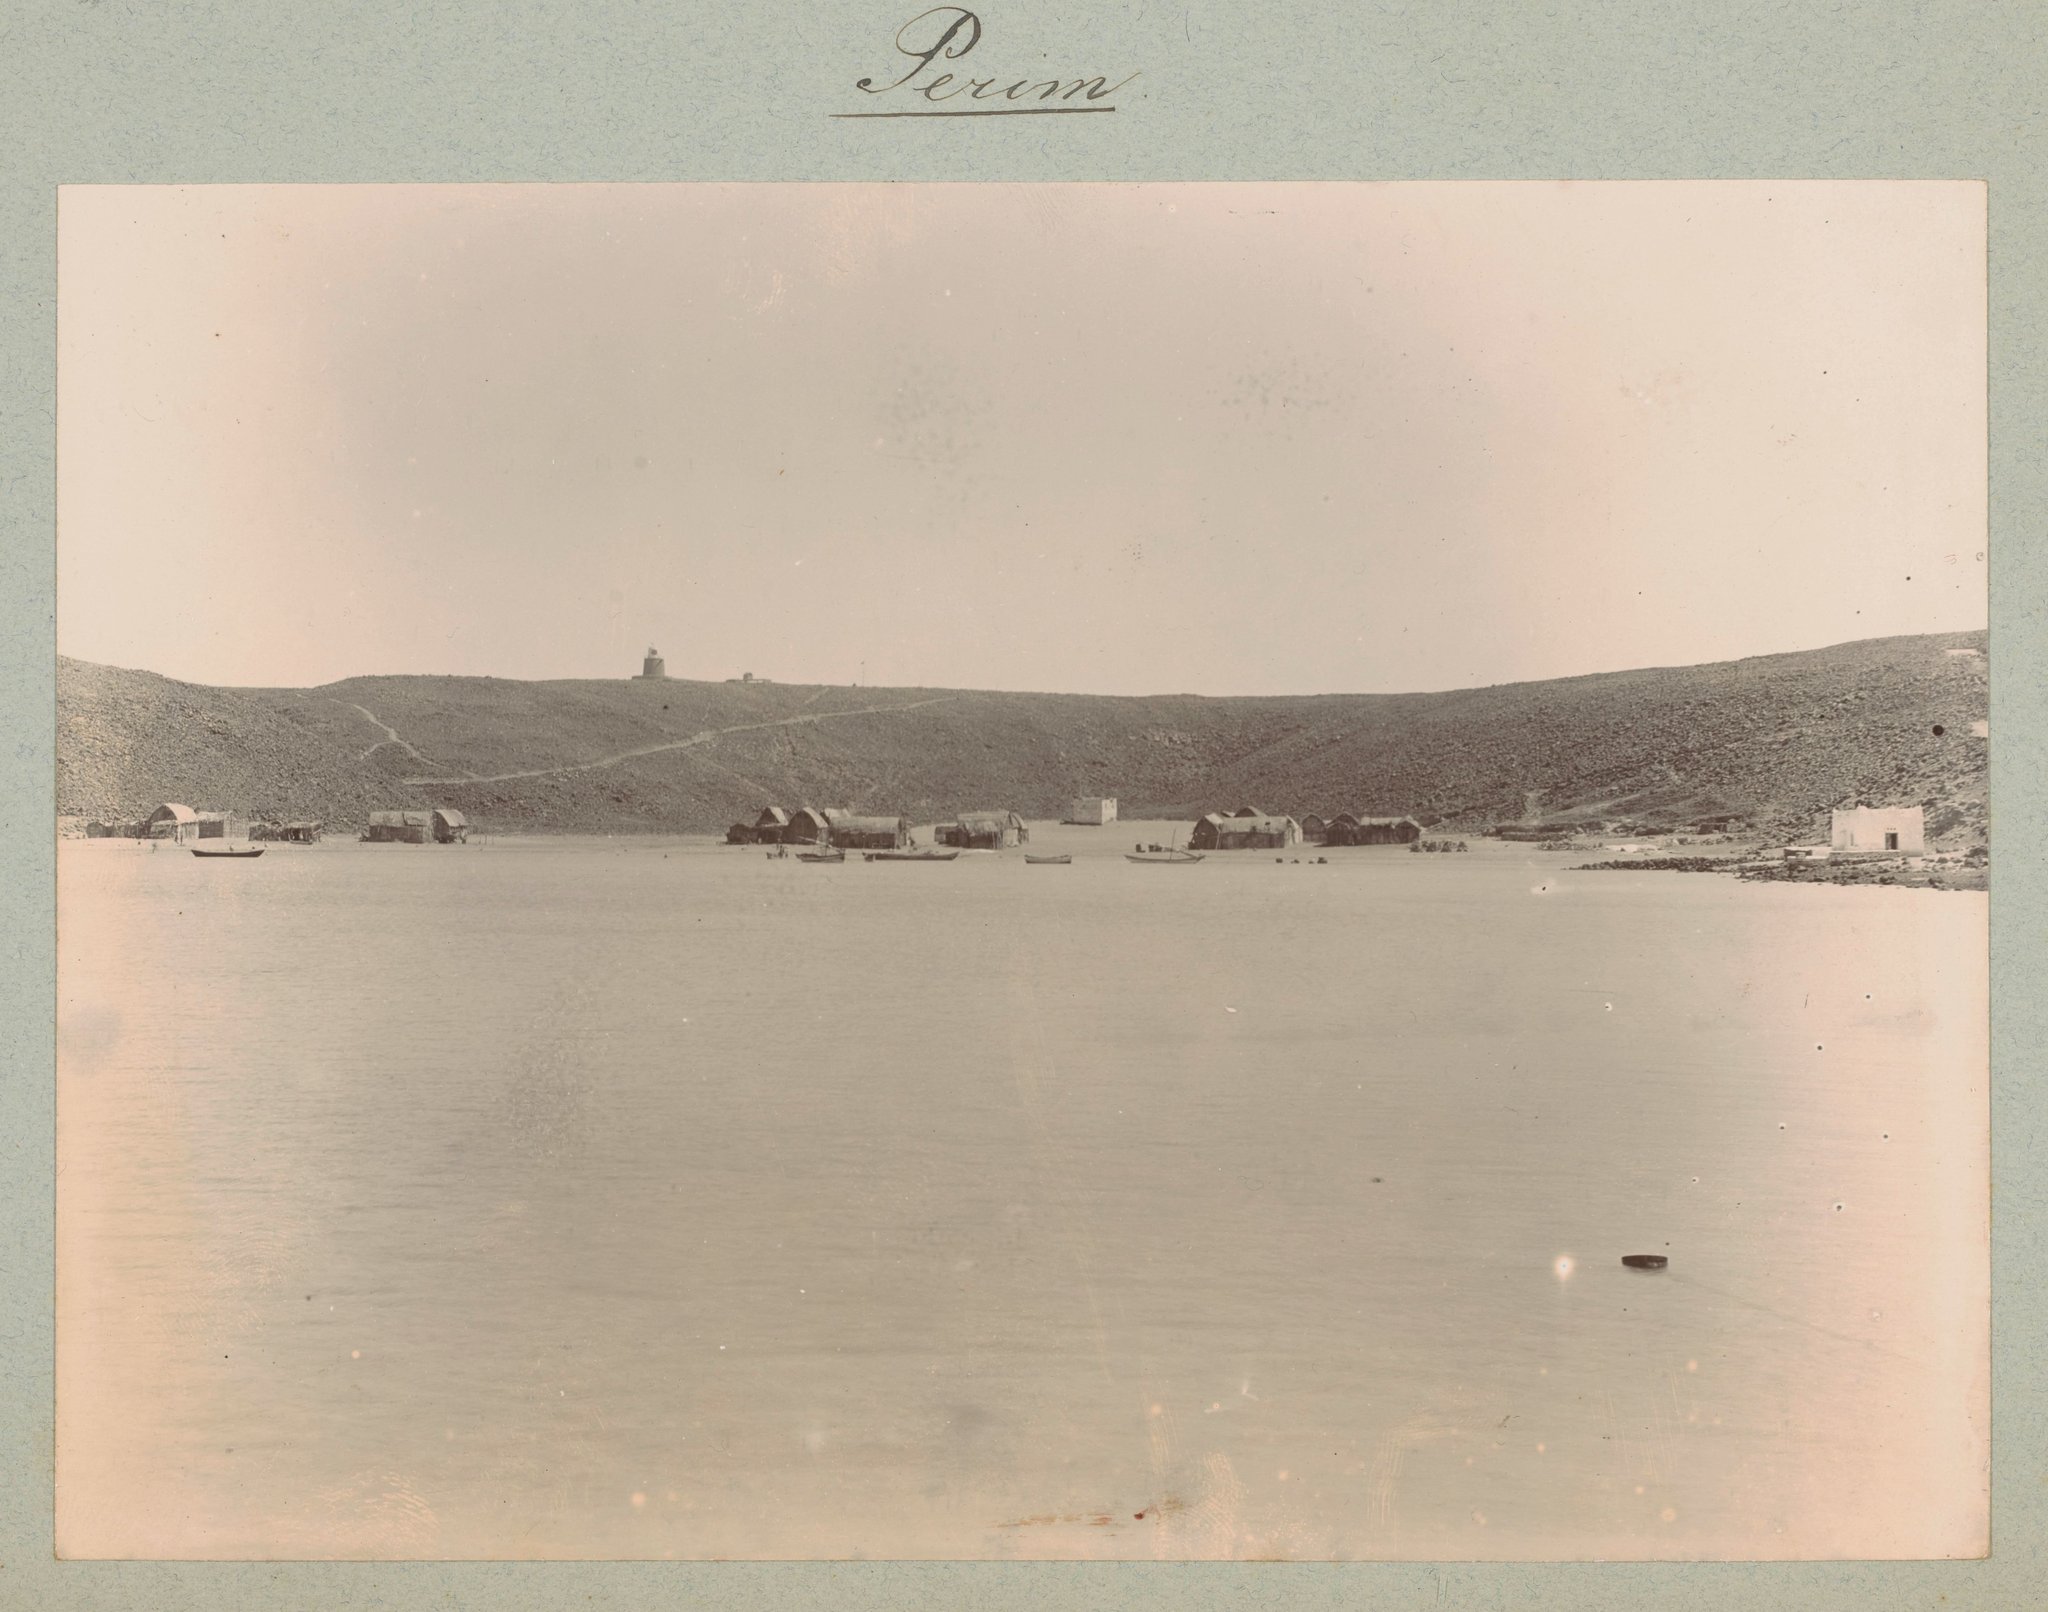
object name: photograph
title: Perim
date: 1904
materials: paper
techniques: gelatin silver print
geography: perim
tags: coast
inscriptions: inscription: ‘Perim’